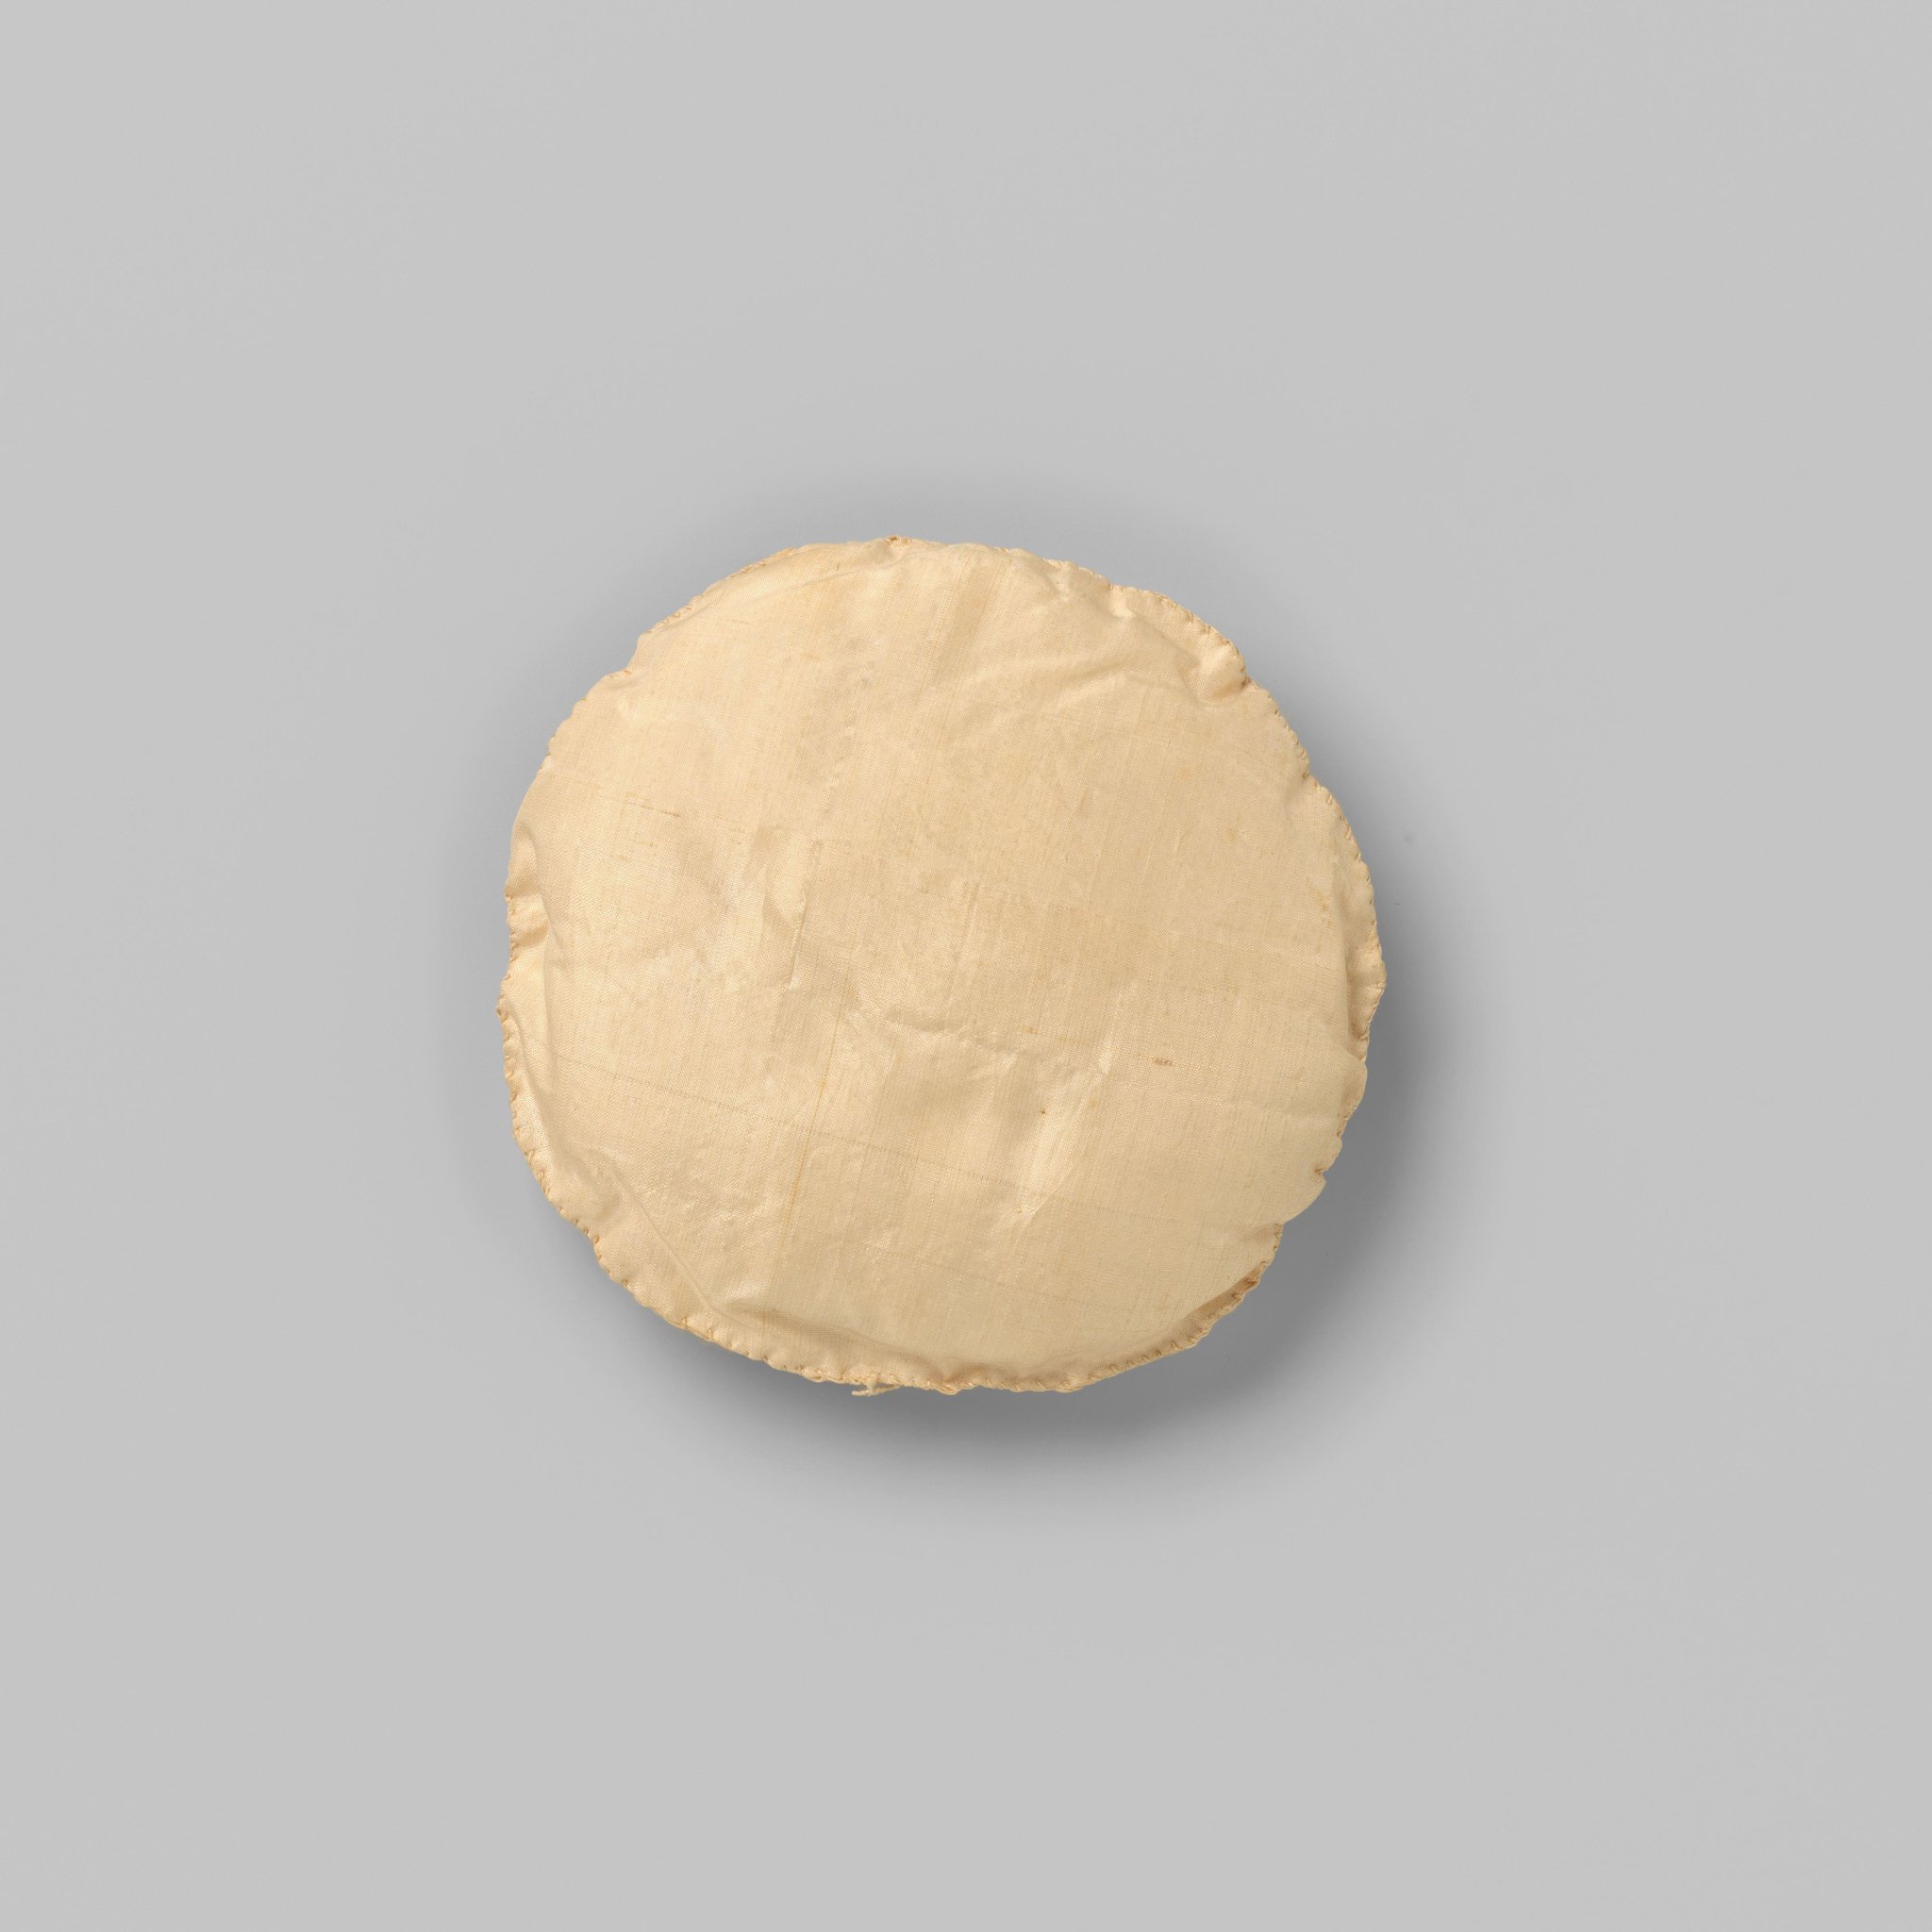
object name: cushion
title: Tea service for two people (tête-à-tête)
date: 1775-1778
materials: silk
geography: vienna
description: Rond kussentje van witte zijde, behorend bij tête-à-tête in lederen etui. (Het servies is door Keizerin Maria Theresia geschonken aan de schilder J.E. Liotard bij zijn vertrek uit Wenen op 5 juni 1778.)